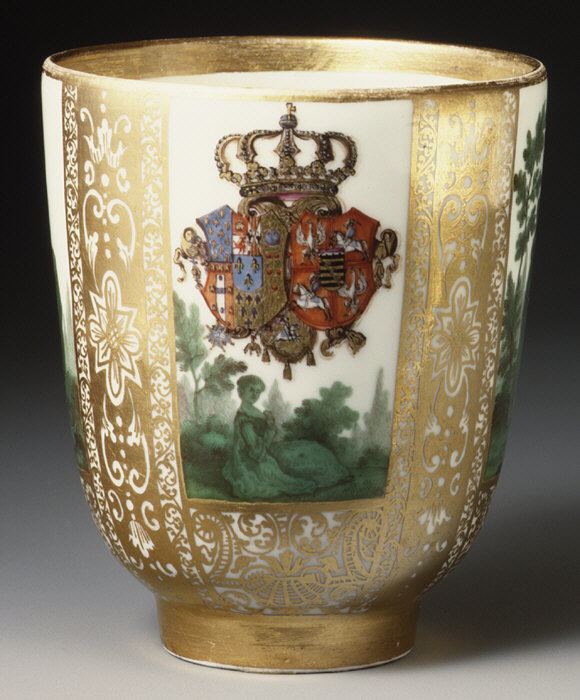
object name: cup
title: Cup with the Arms of Poland/Saxony and Naples/Sicily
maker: meissen manufactory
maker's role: manufactory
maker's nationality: german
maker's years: 1710-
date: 1745-1747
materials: hard paste porcelain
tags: women,coat of arms